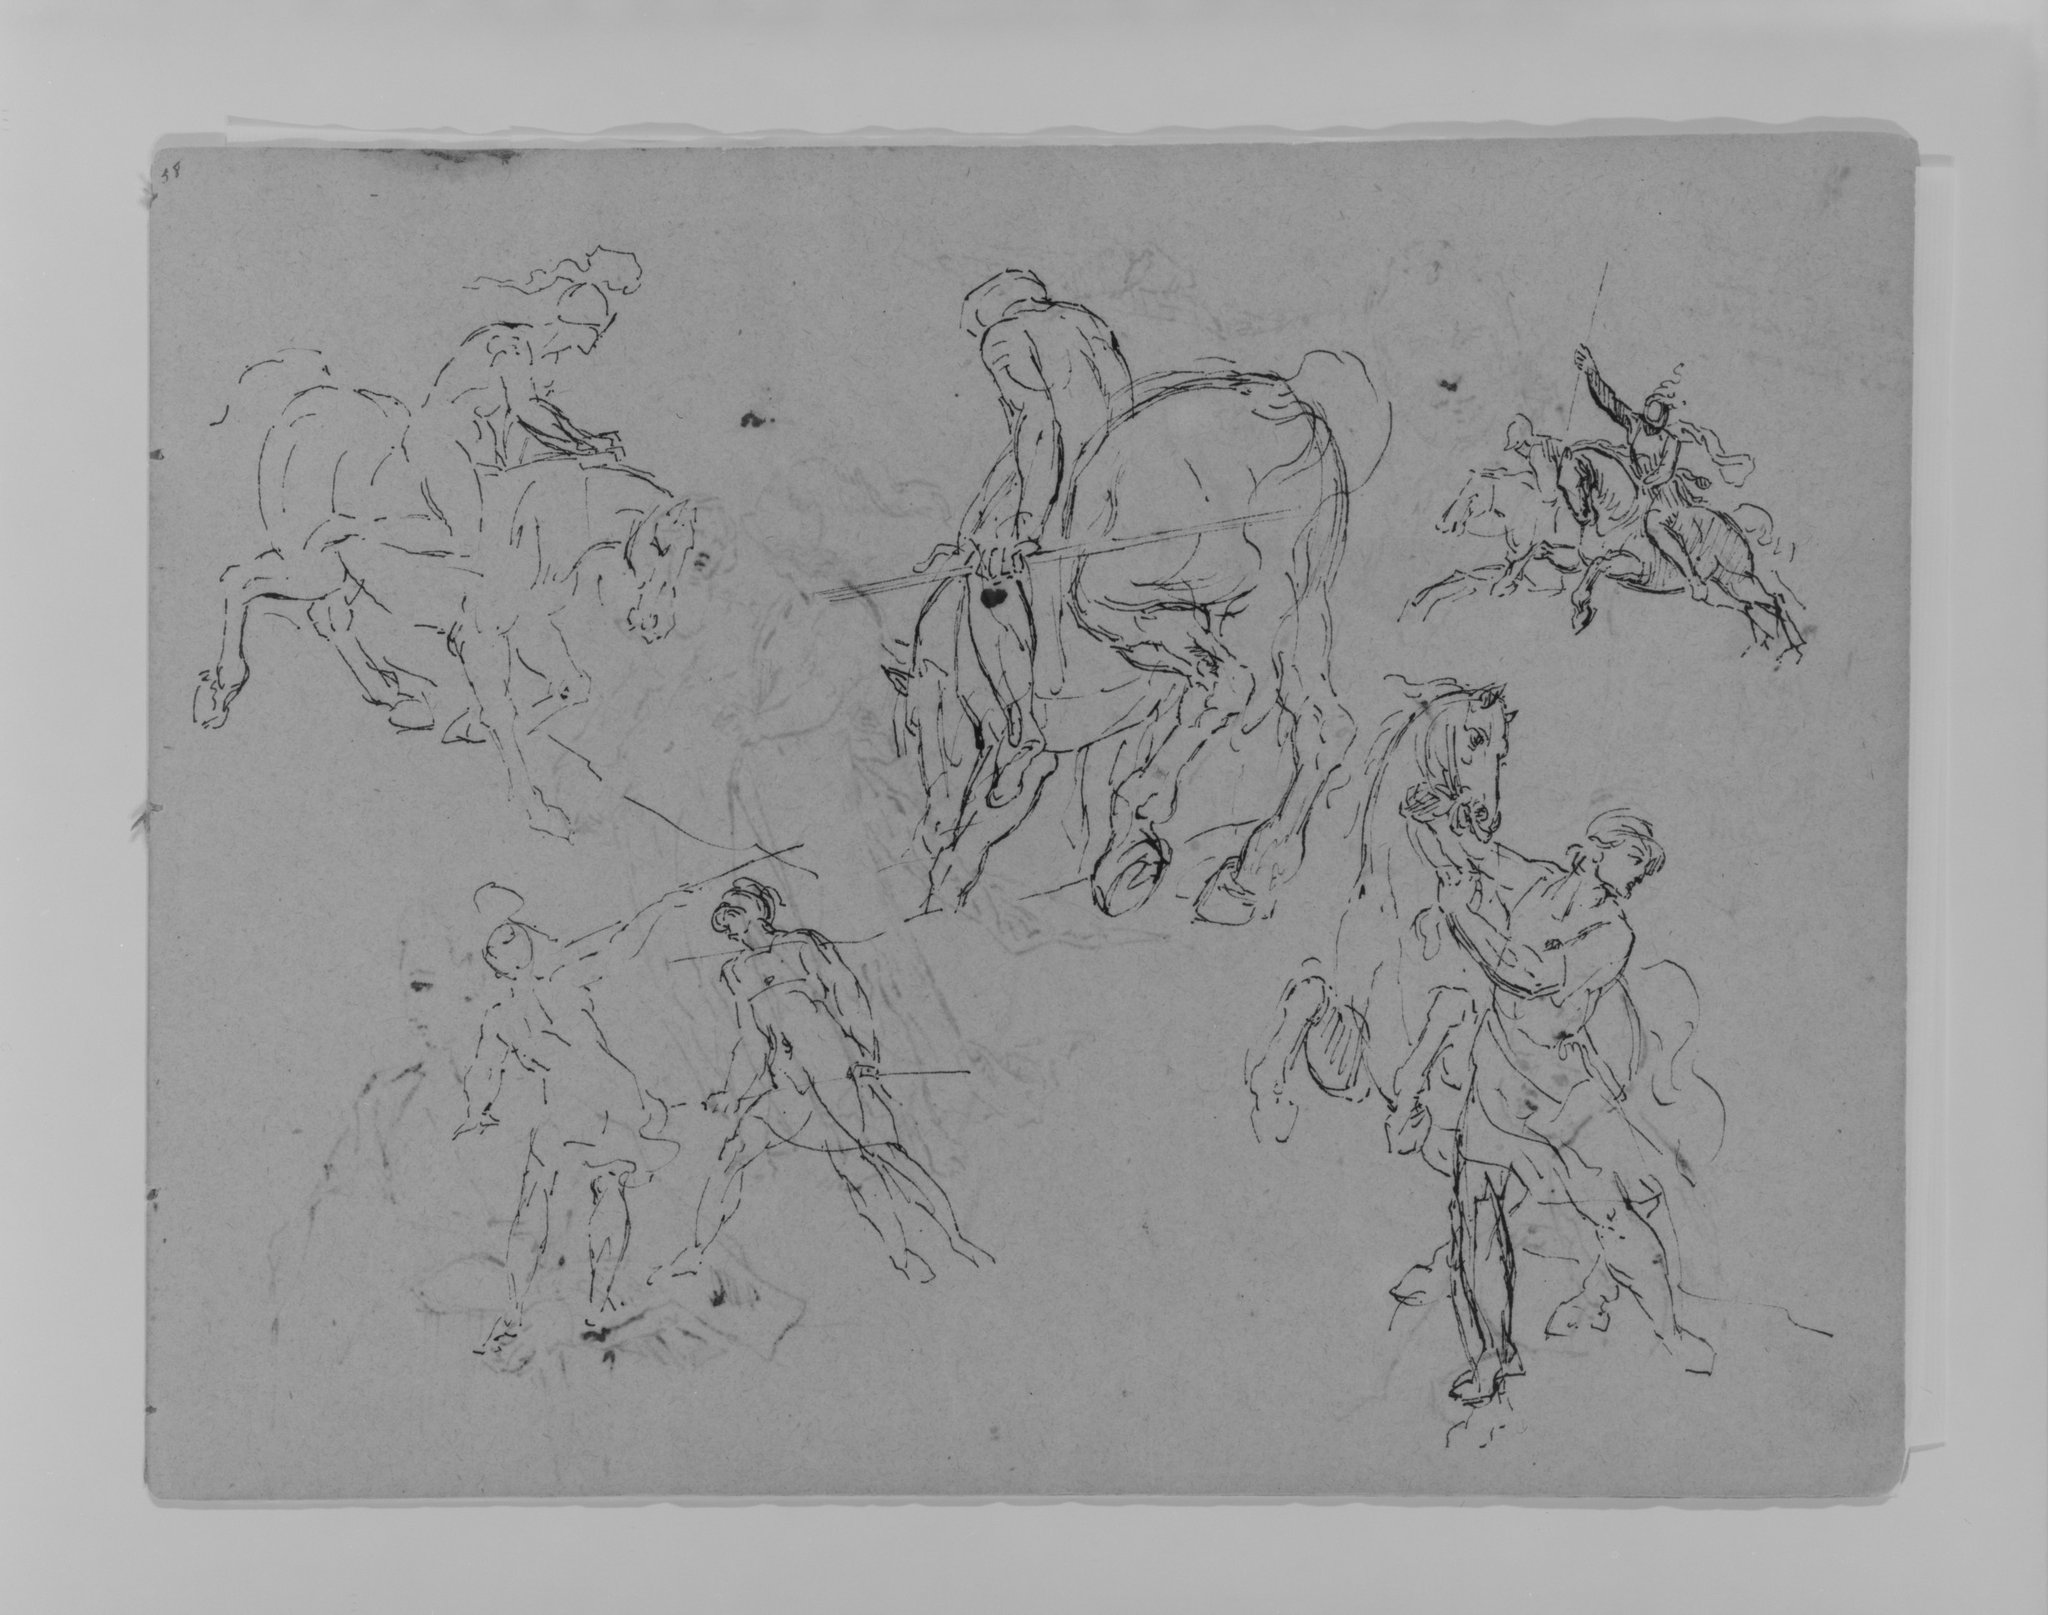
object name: drawing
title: (From Sketchbook)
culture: american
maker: thomas sully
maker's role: artist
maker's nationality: american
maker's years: 1783-1872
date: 1810-1820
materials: ink, paper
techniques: wash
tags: men,horses